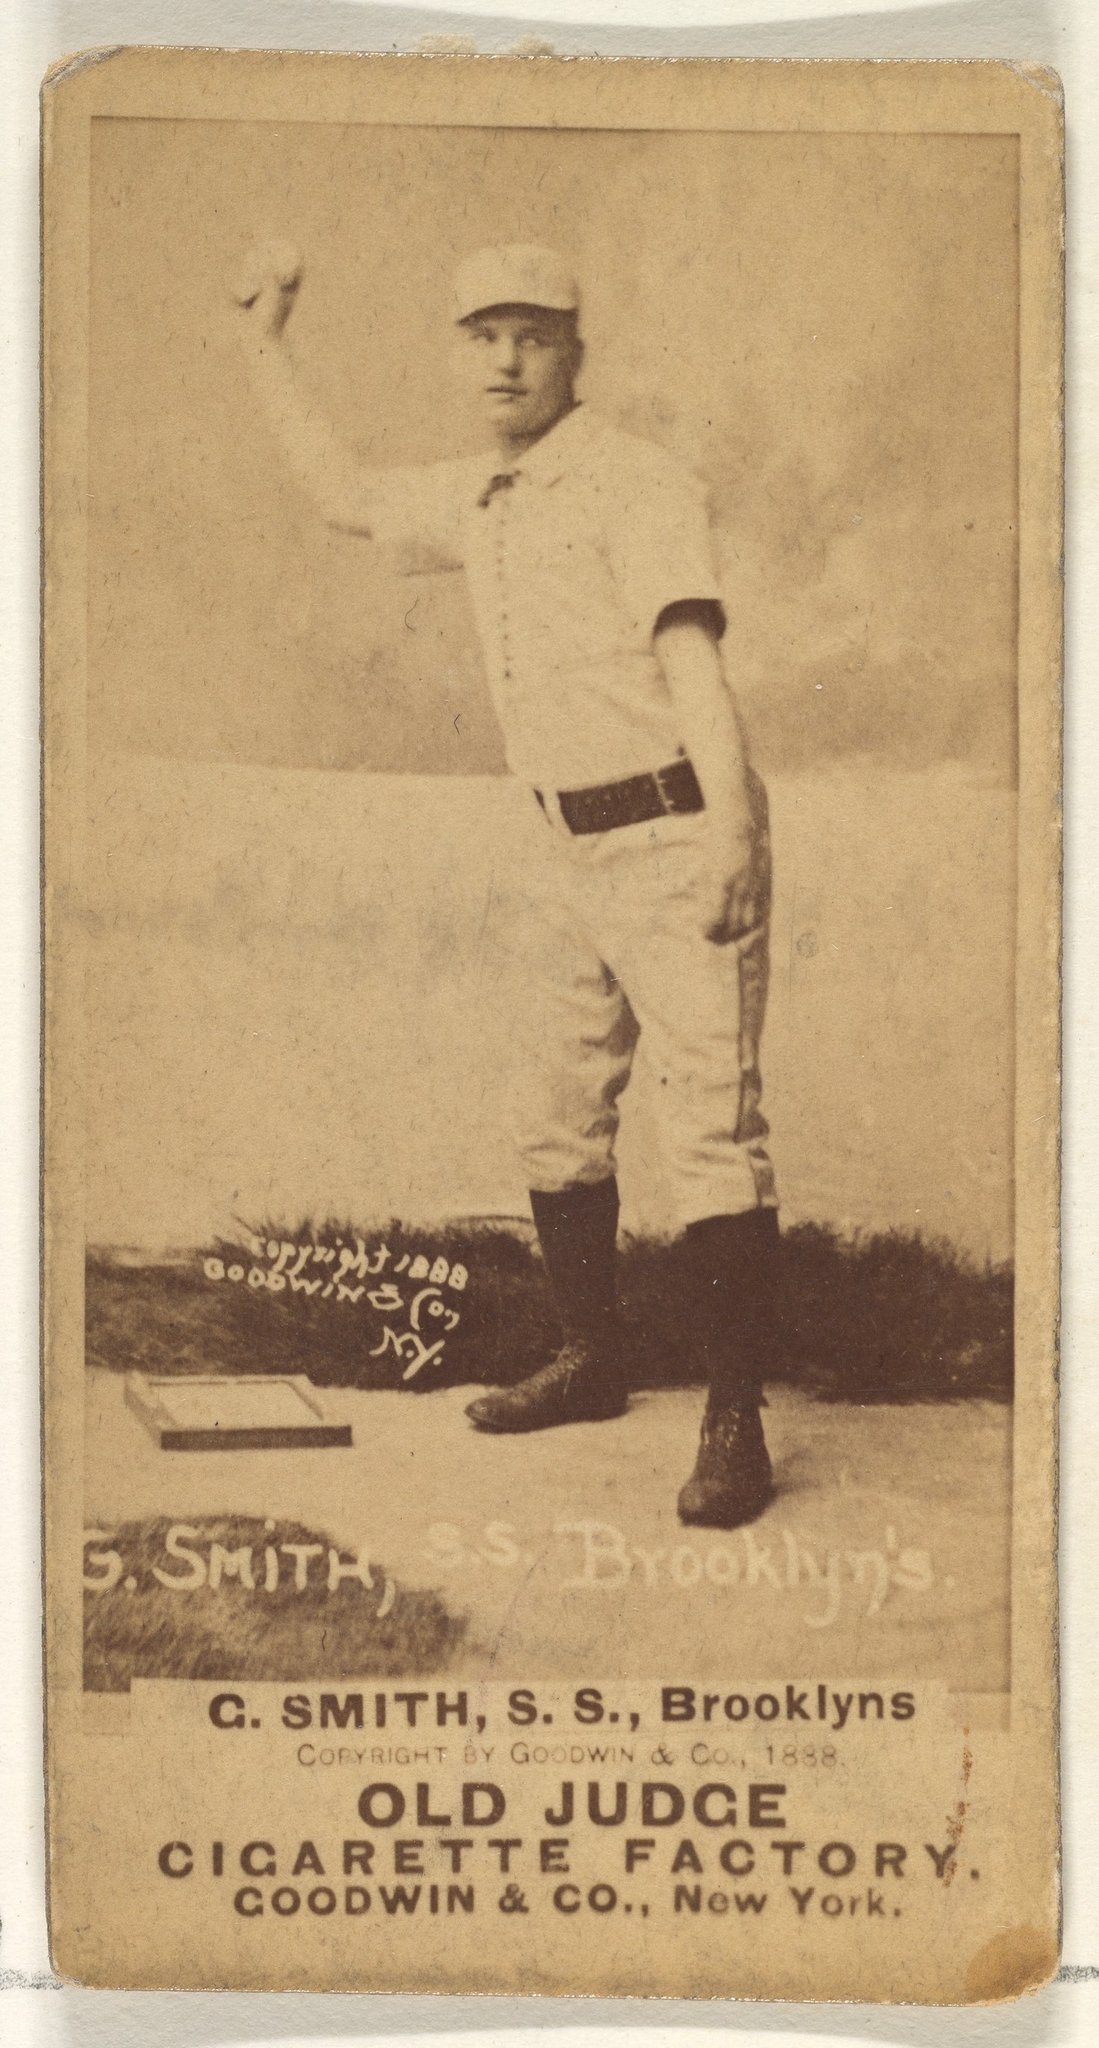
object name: baseball card, photograph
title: G. Smith, Shortstop, Brooklyn Bridegrooms, from the Old Judge series (N172) for Old Judge Cigarettes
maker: goodwin & company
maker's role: publisher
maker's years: 1850-1950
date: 1888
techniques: albumen silver print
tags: men,portraits,baseball,athletes